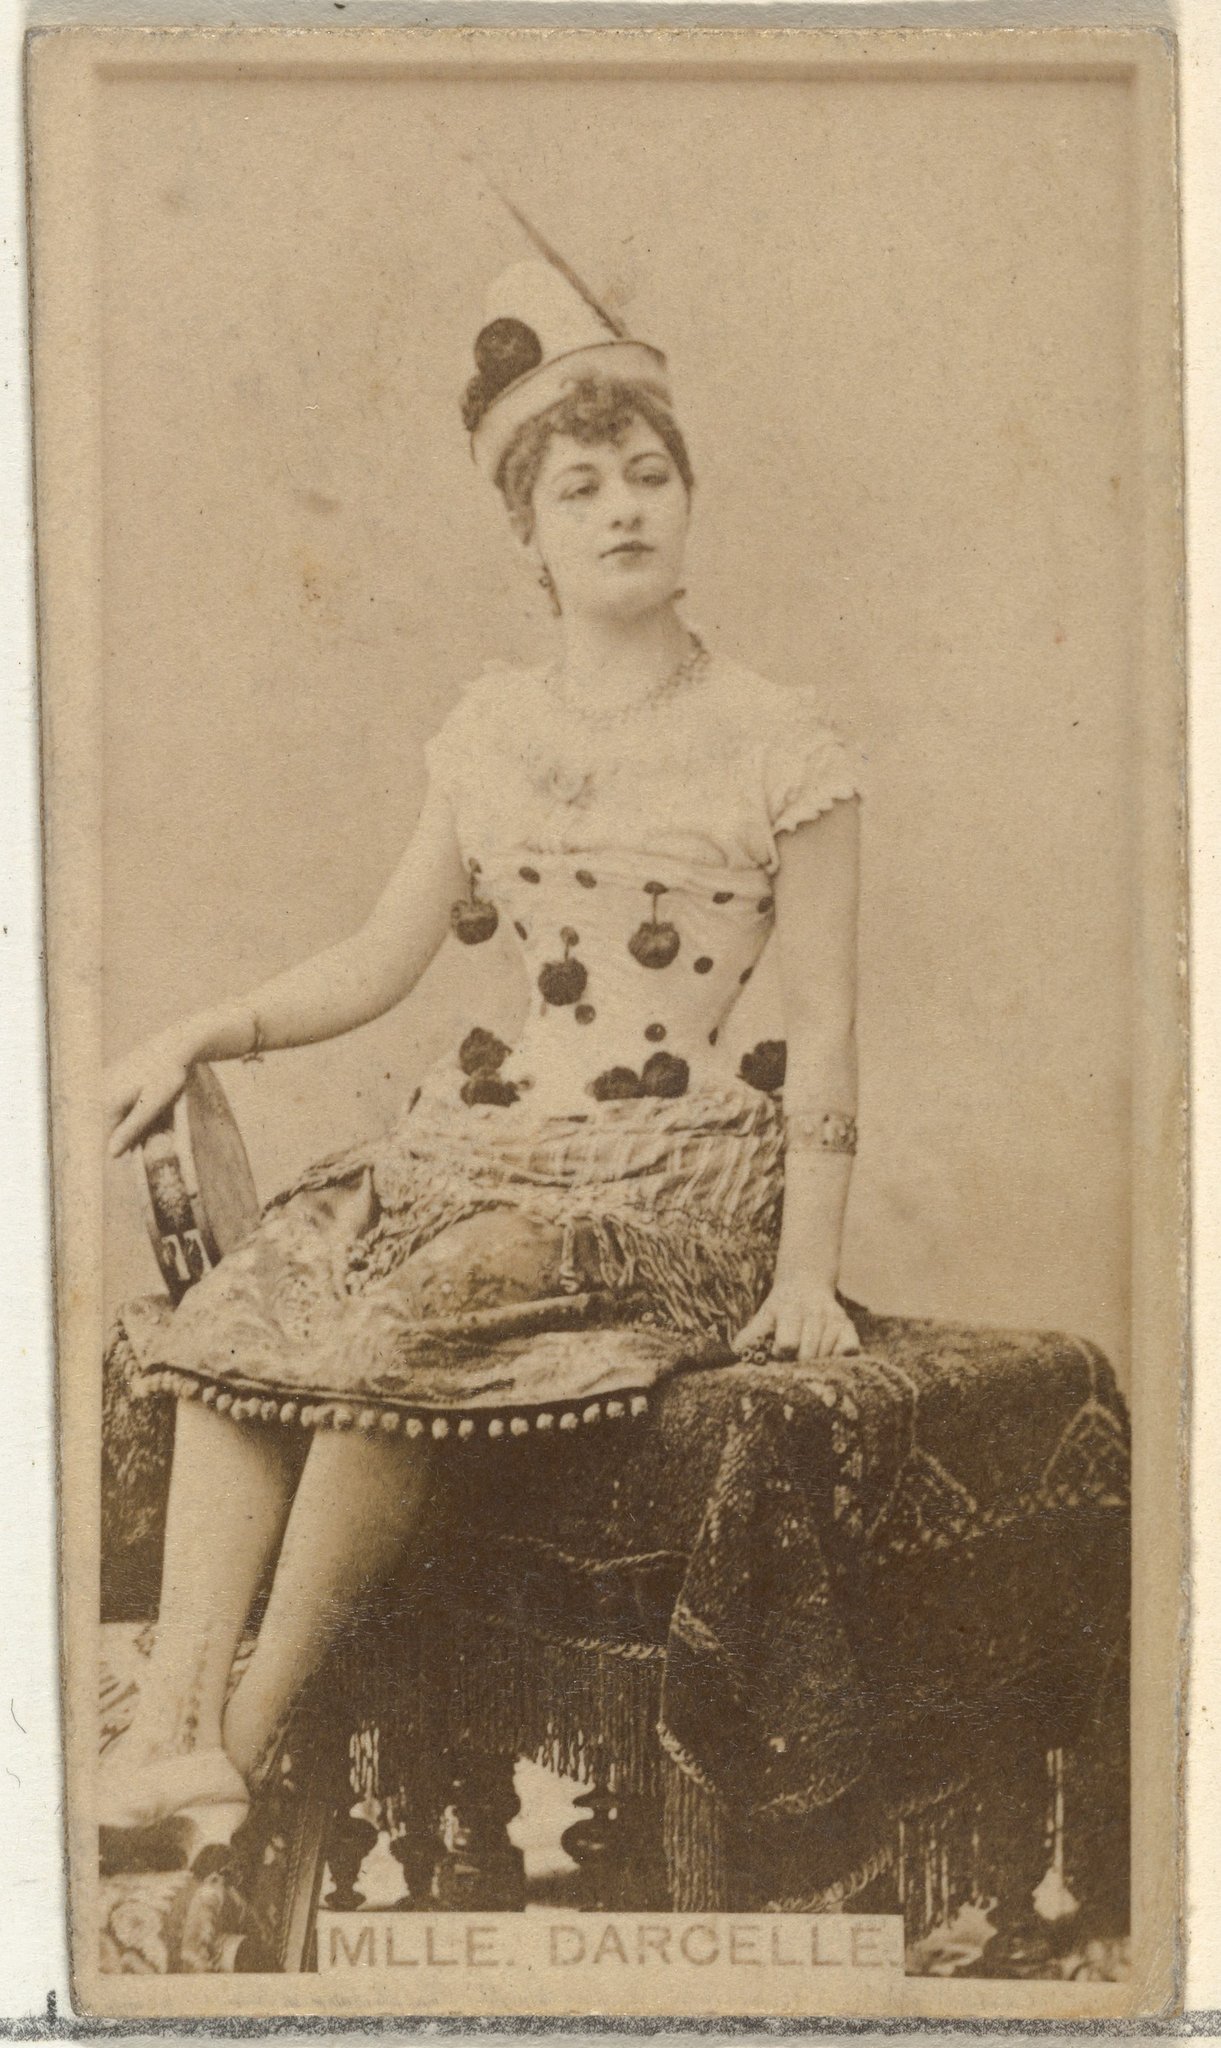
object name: photograph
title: Mlle. Darcelle, from the Actors and Actresses series (N145-8) issued by Duke Sons & Co. to promote Duke Cigarettes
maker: w. duke, sons & co.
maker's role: publisher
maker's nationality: american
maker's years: 1870-1920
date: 1891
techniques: albumen silver print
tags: portraits,women,actresses